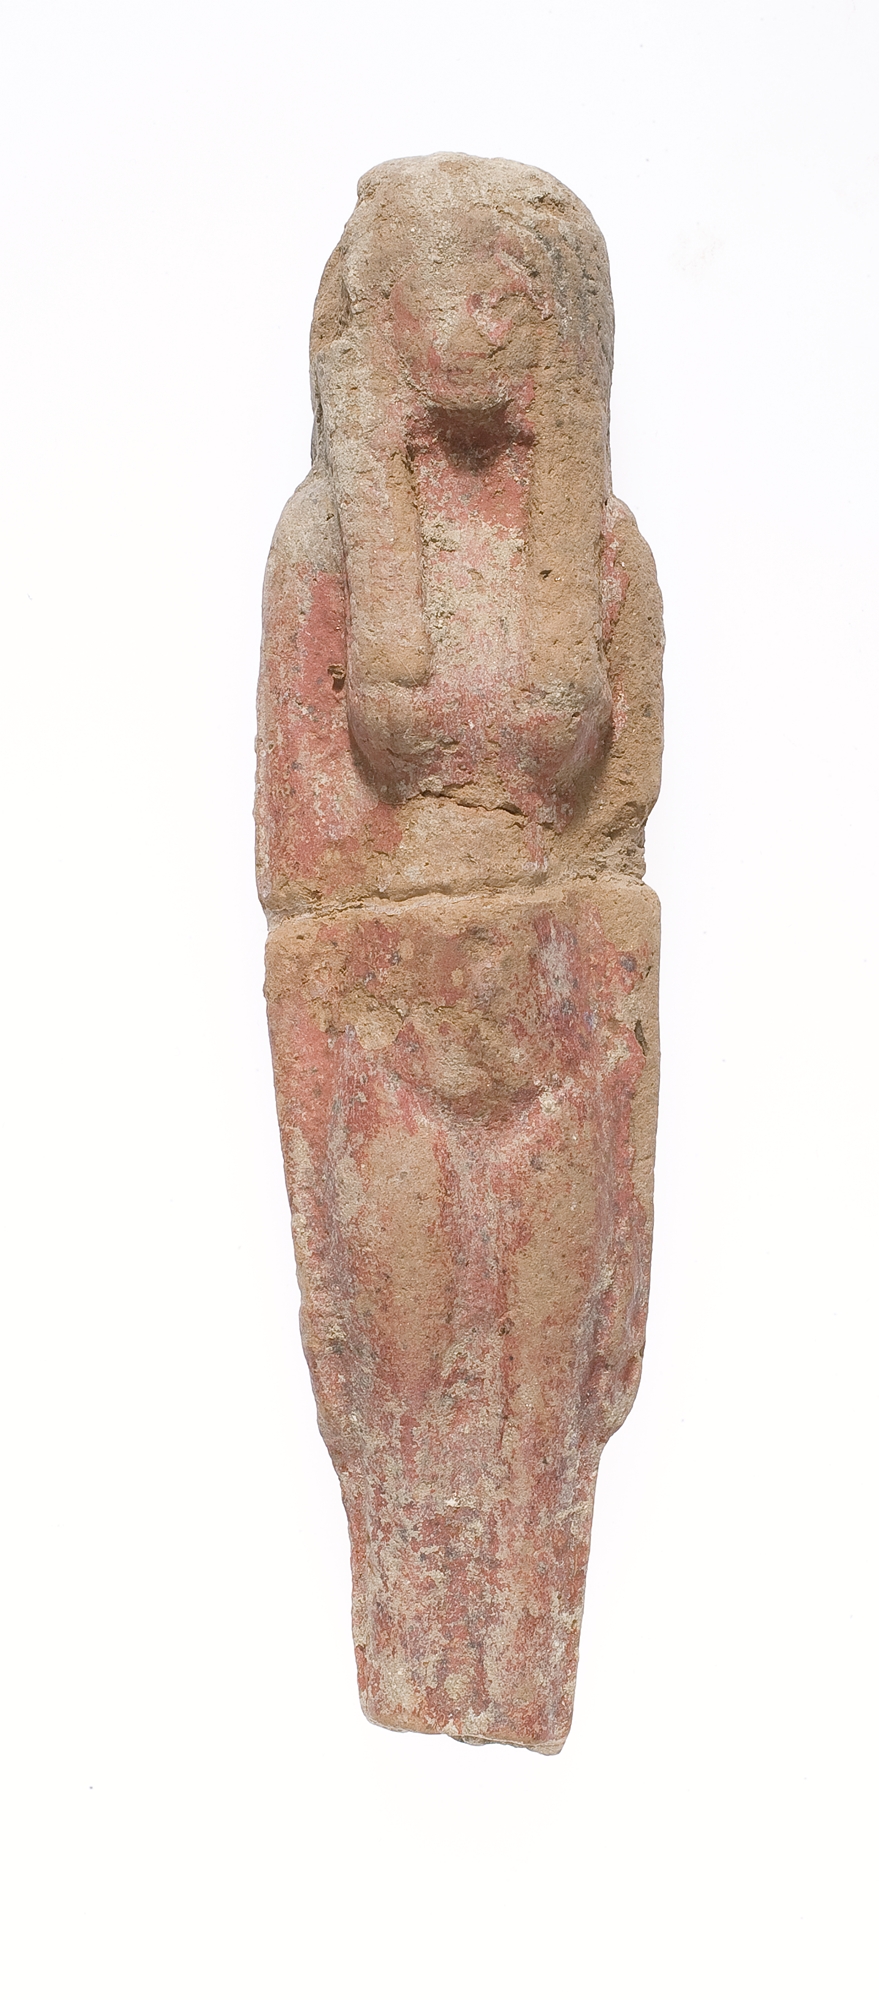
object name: statuette of a woman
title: Standing female figurine with long thin wig and missing legs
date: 1390-1186 BCE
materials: pottery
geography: egypt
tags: women